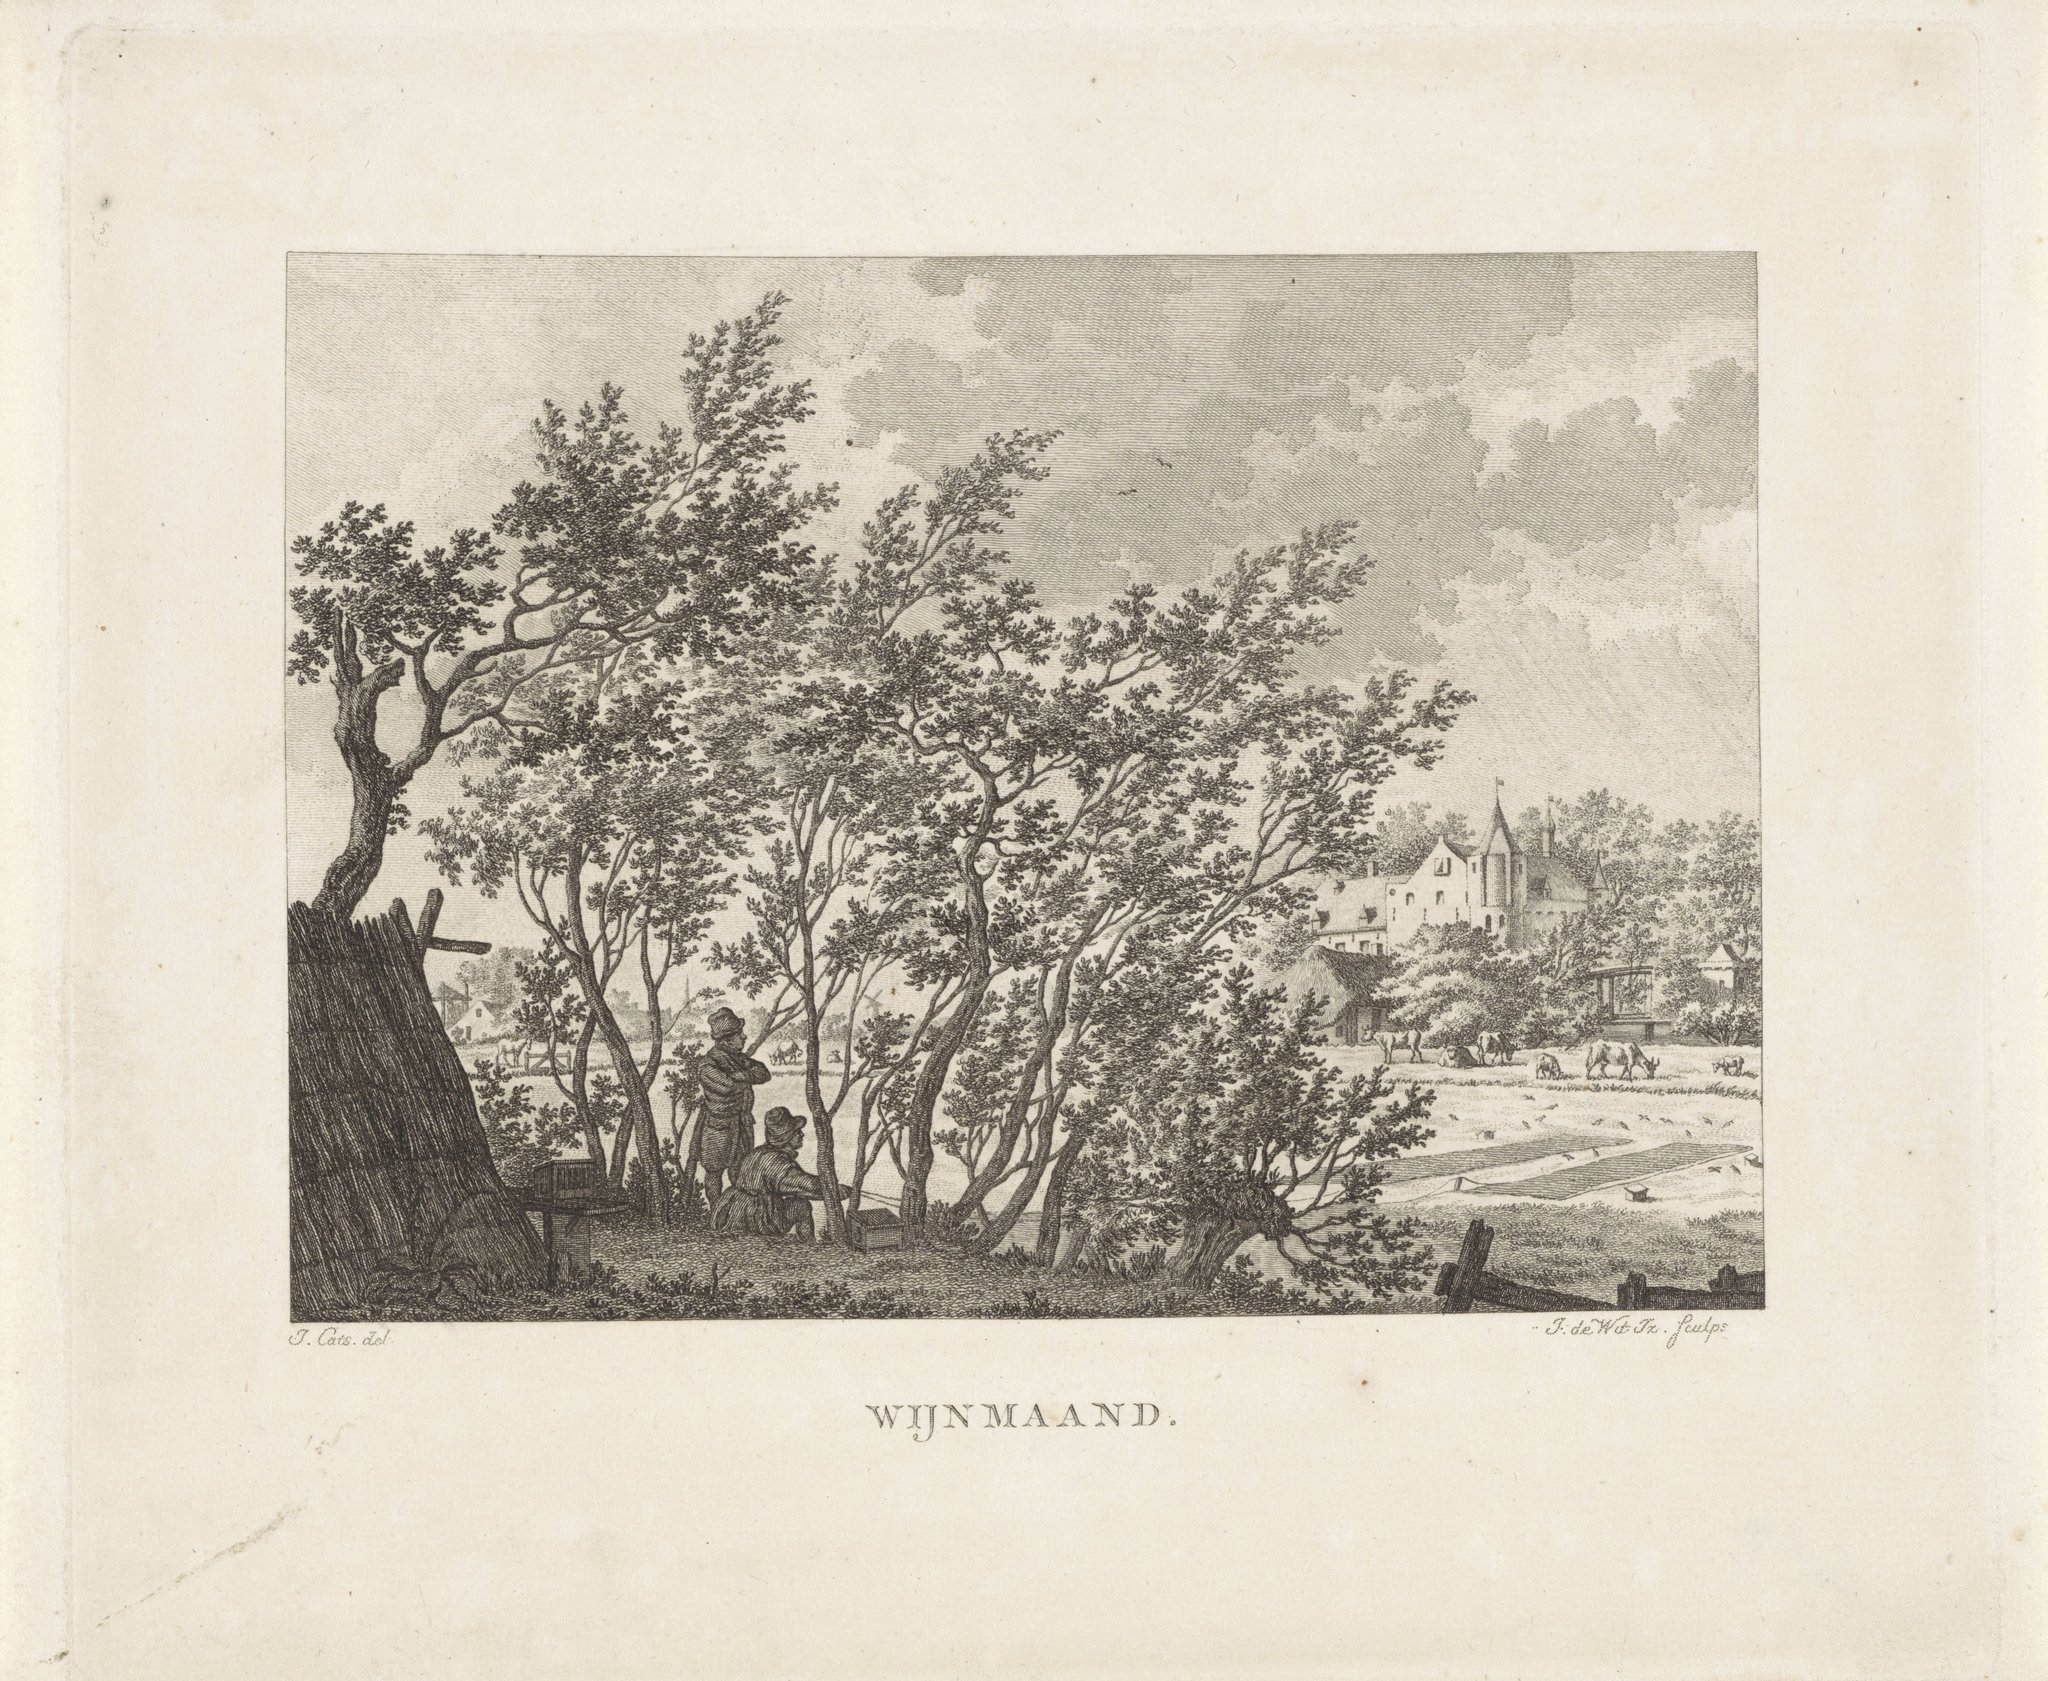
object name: print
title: Wijnmaand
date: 1807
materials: paper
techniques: etching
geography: haarlem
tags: october and its 'labours' (+ with scenes showing human occupations ~ seasons and months), landscape with tower or castle, fowling, fowler, finch trap, finchery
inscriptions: signature and date: ‘r.o.: I. de Wit Jz. fc; l.o.: J. Cats del.’, inscription: ‘m.o.: WIJNMAAND’, collector's mark: Lugt 2228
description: Twee vogelvangers zitten onder de bomen en hebben hun netten gespannen in het veld. Een kasteel op de achtergrond.